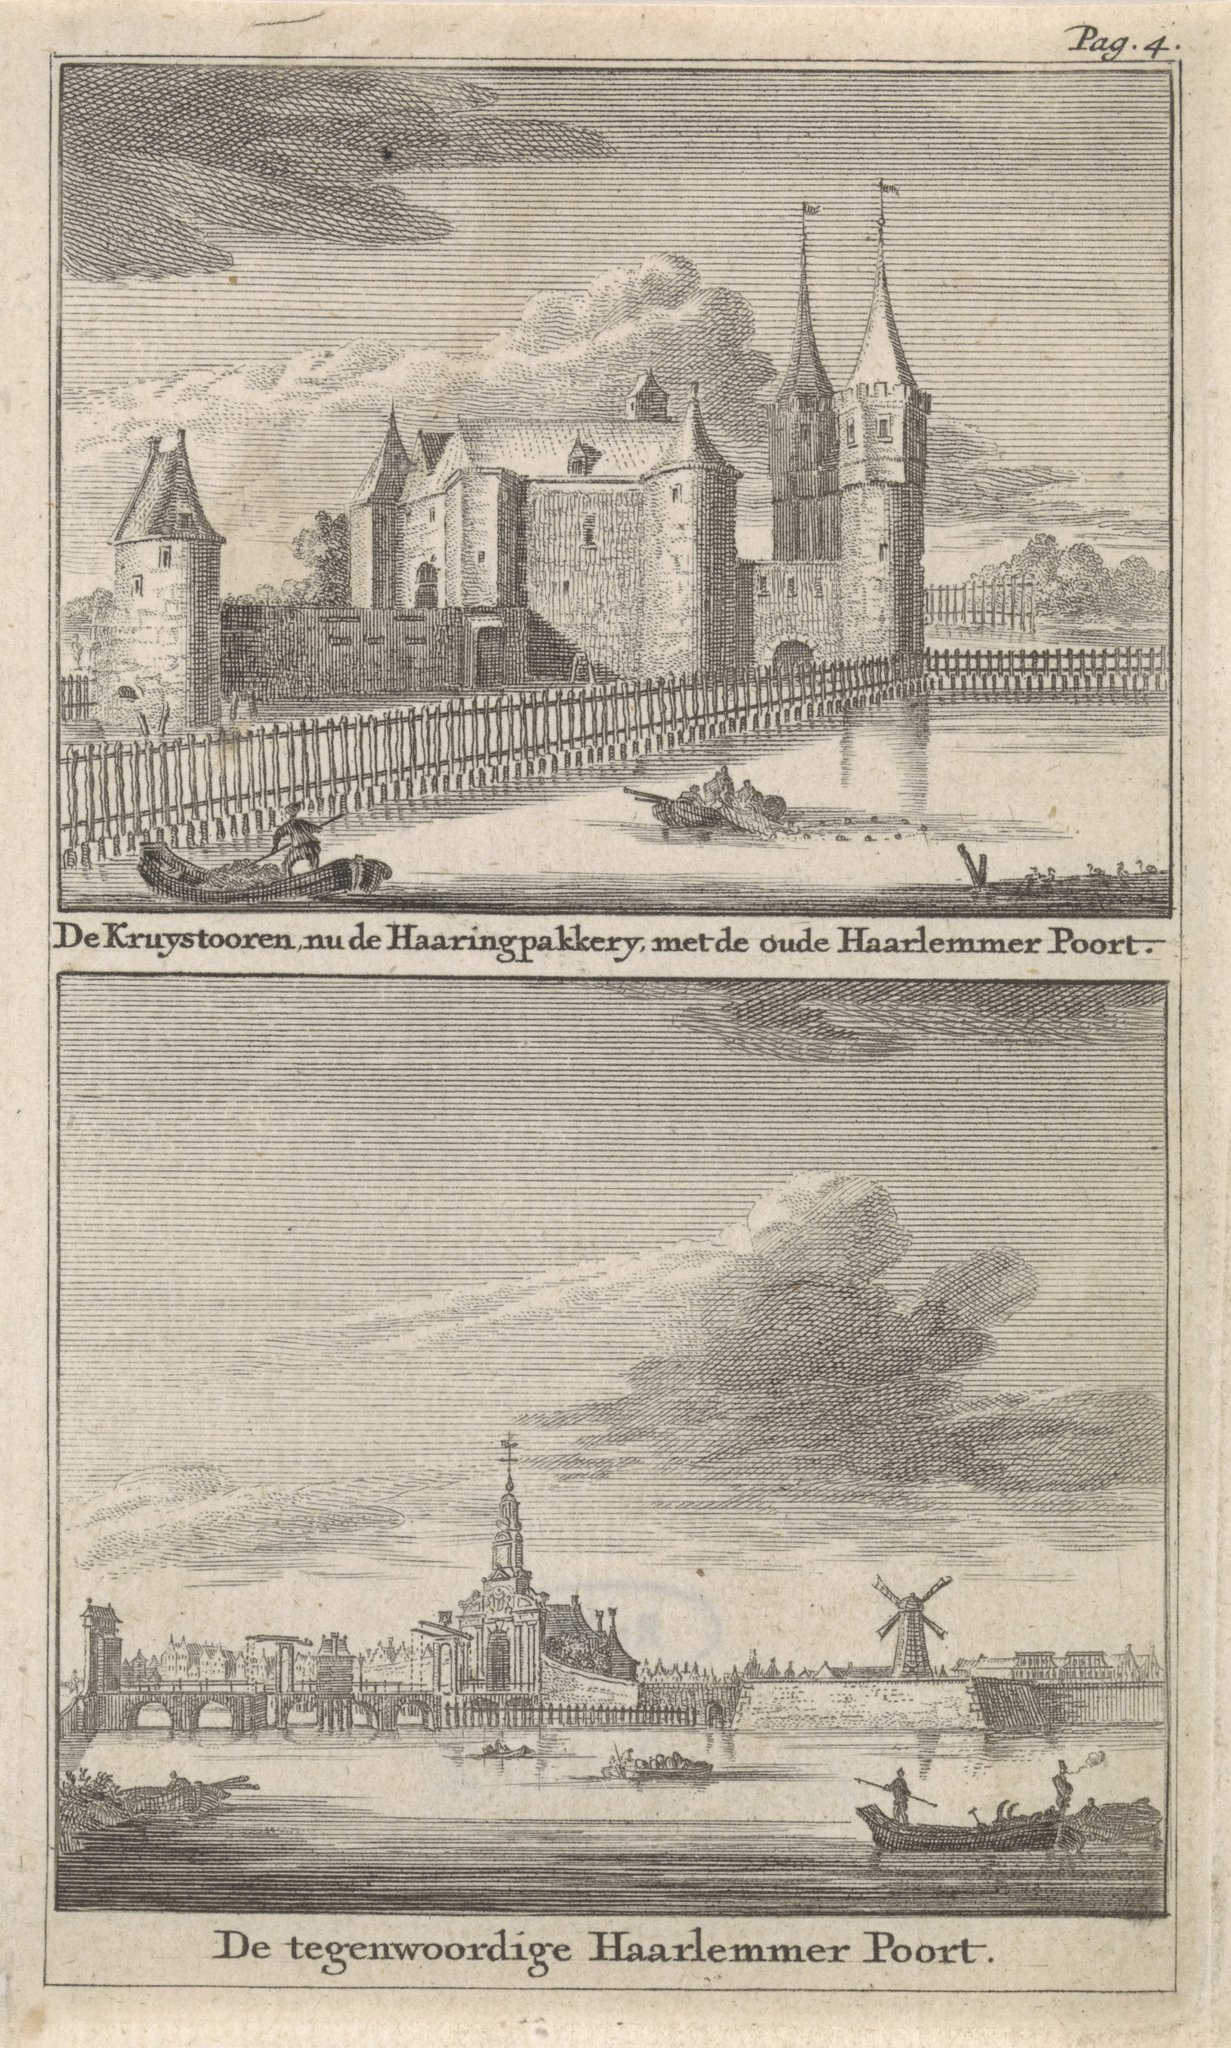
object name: book illustration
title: Gezicht op de Haringpakkerstoren en de Haarlemmerpoort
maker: jan goeree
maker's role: draughtsman, print maker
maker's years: 1670-1731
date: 1723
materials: paper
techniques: engraving, etching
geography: amsterdam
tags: city-walls (+ city(-scape) with figures, staffage)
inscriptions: collector's mark: Lugt 2228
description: Voor wat betreft de bovenste prent is de Haringpakkerstoren de toren uiterst links, de twee torens rechts in beeld horen tot de tweede Haarlemmerpoort. Het gaat om een historiserende afbeelding. In de 18e eeuw had de Haringpakkerstoren een andere spits dan hier te zien is. Waarschijnlijk bedoelt deze prent de situatie weer te geven in de late 15e of vroege 16e eeuw, toen de toren (geheel links) nog de Heilige Kruistoren heette. Boekillustratie uit David Willink, Amsterdamsche buitensingel nevens de omleggende dorpen, opgeheldert door aantekeningen over veele voornaame geschiedeniszen. Amsterdam bij A. van Damme, 1723.